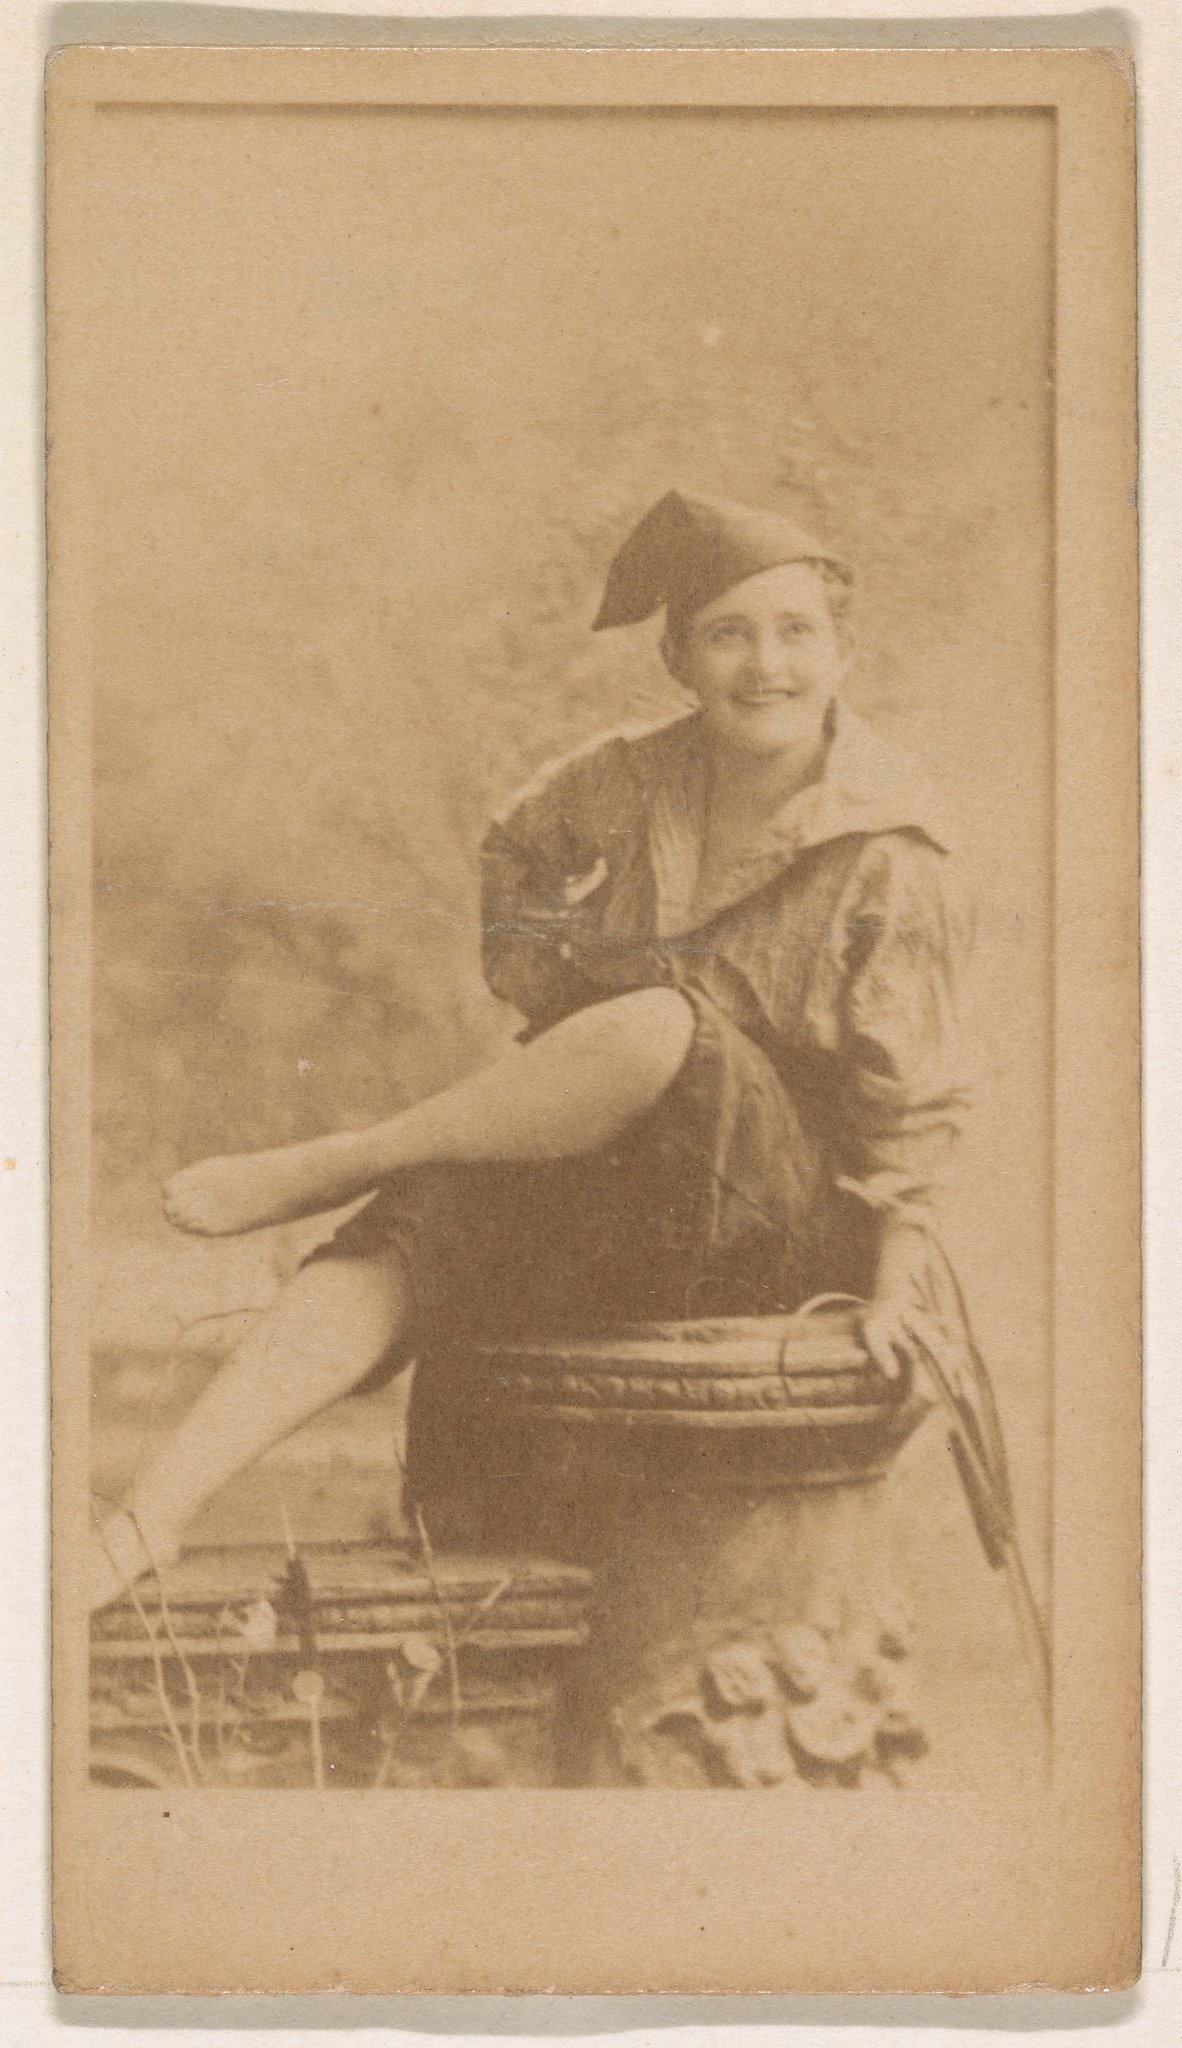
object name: photograph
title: Seated actress wearing cap, from the Actresses series (N245) issued by Kinney Brothers to promote Sweet Caporal Cigarettes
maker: kinney brothers tobacco company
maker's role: publisher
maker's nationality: american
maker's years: 1869-2011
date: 1890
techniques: albumen silver print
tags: hats,portraits,women,actresses